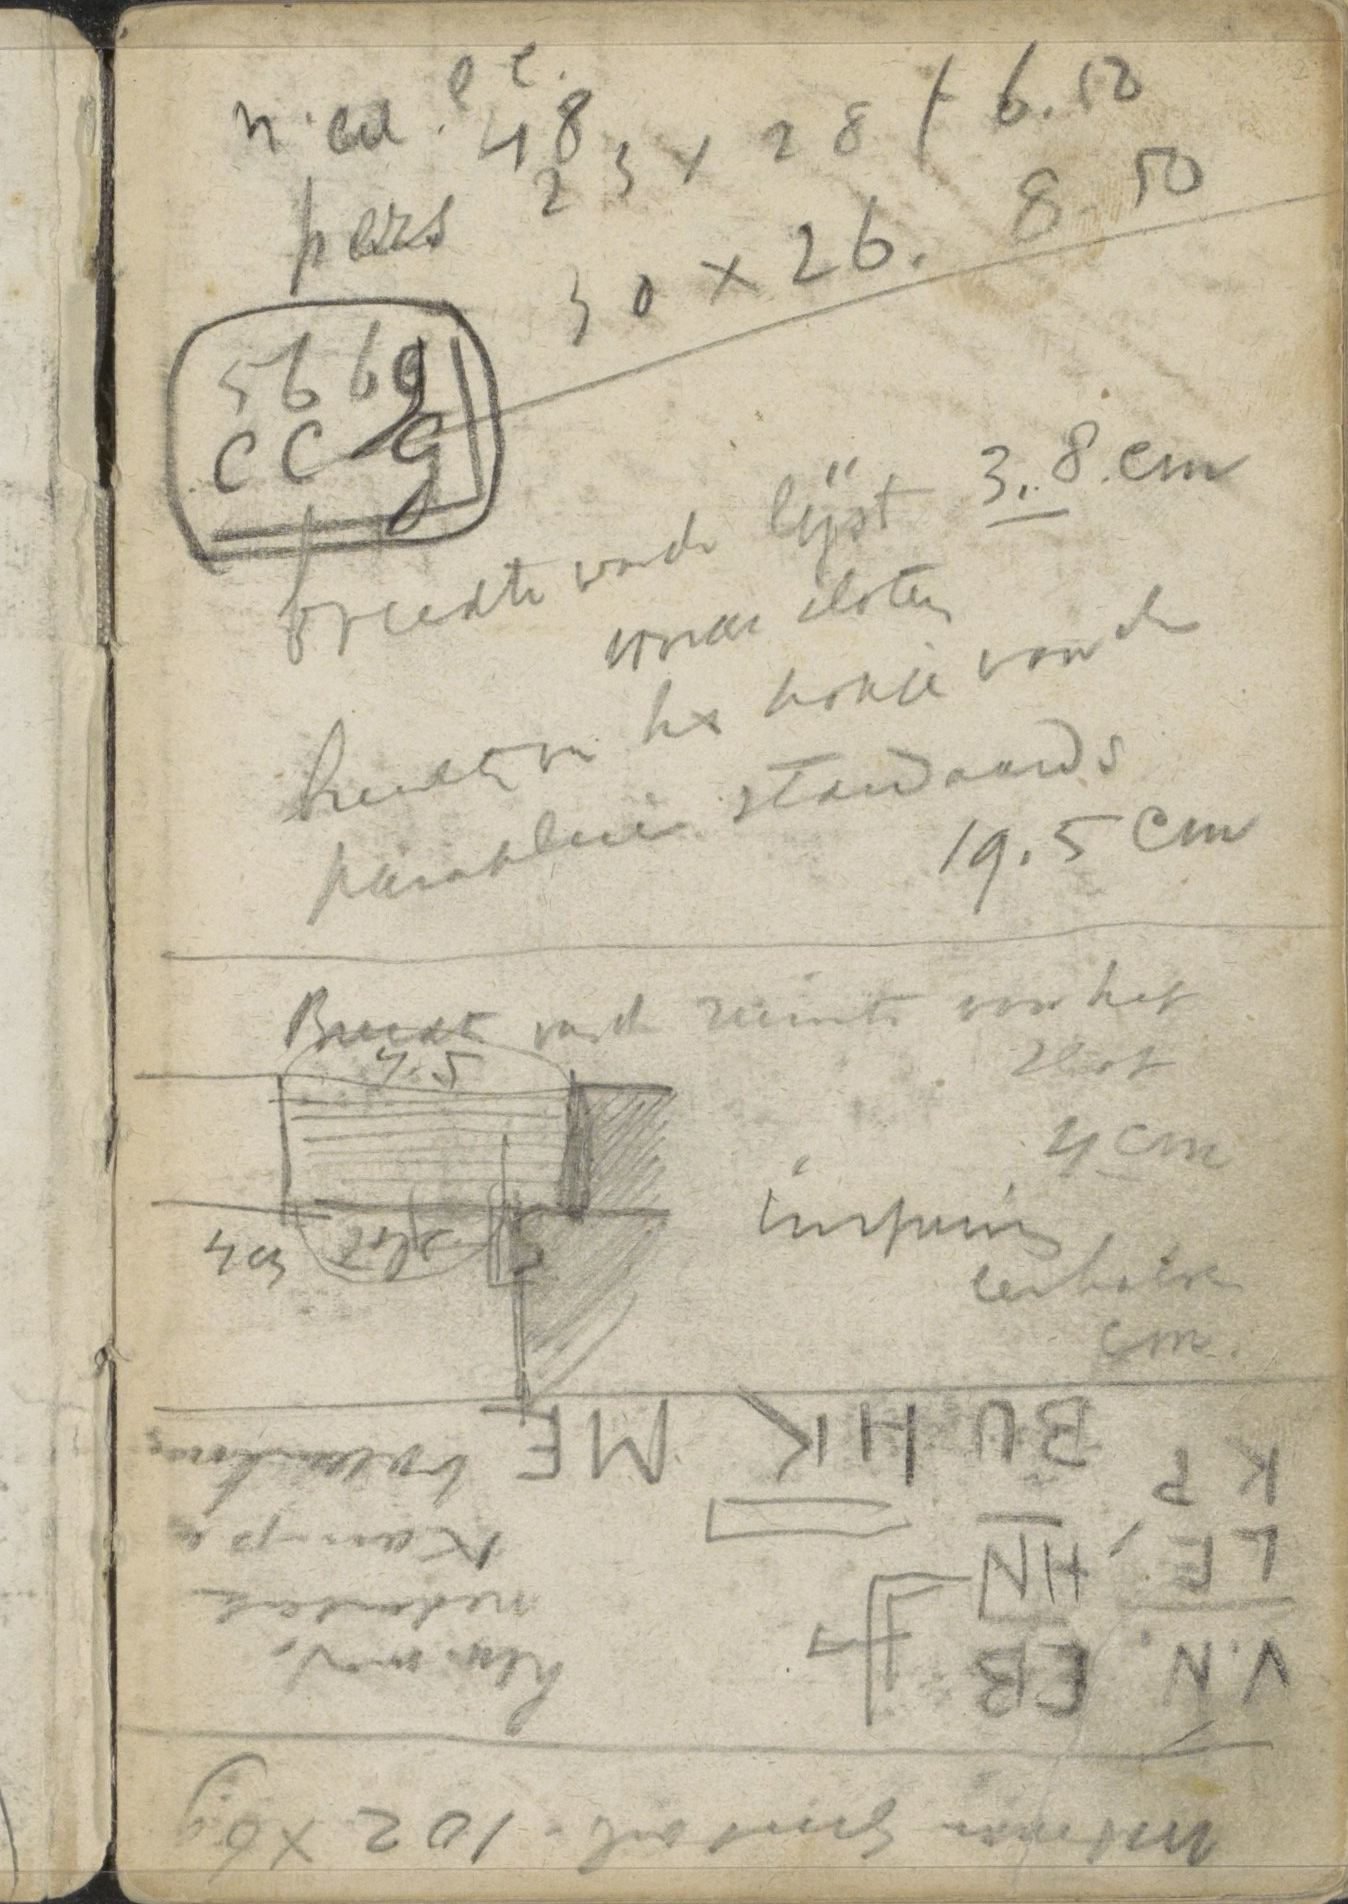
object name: sketchbook leaf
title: Annotaties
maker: george hendrik breitner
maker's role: draughtsman, painter, print maker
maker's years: 1857-1923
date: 1900-1901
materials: chalk, paper, pencil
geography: amsterdam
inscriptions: annotation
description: Annotaties. Pagina 2 uit een schetsboek met 46 bladen vervaardigd te Amsterdam.